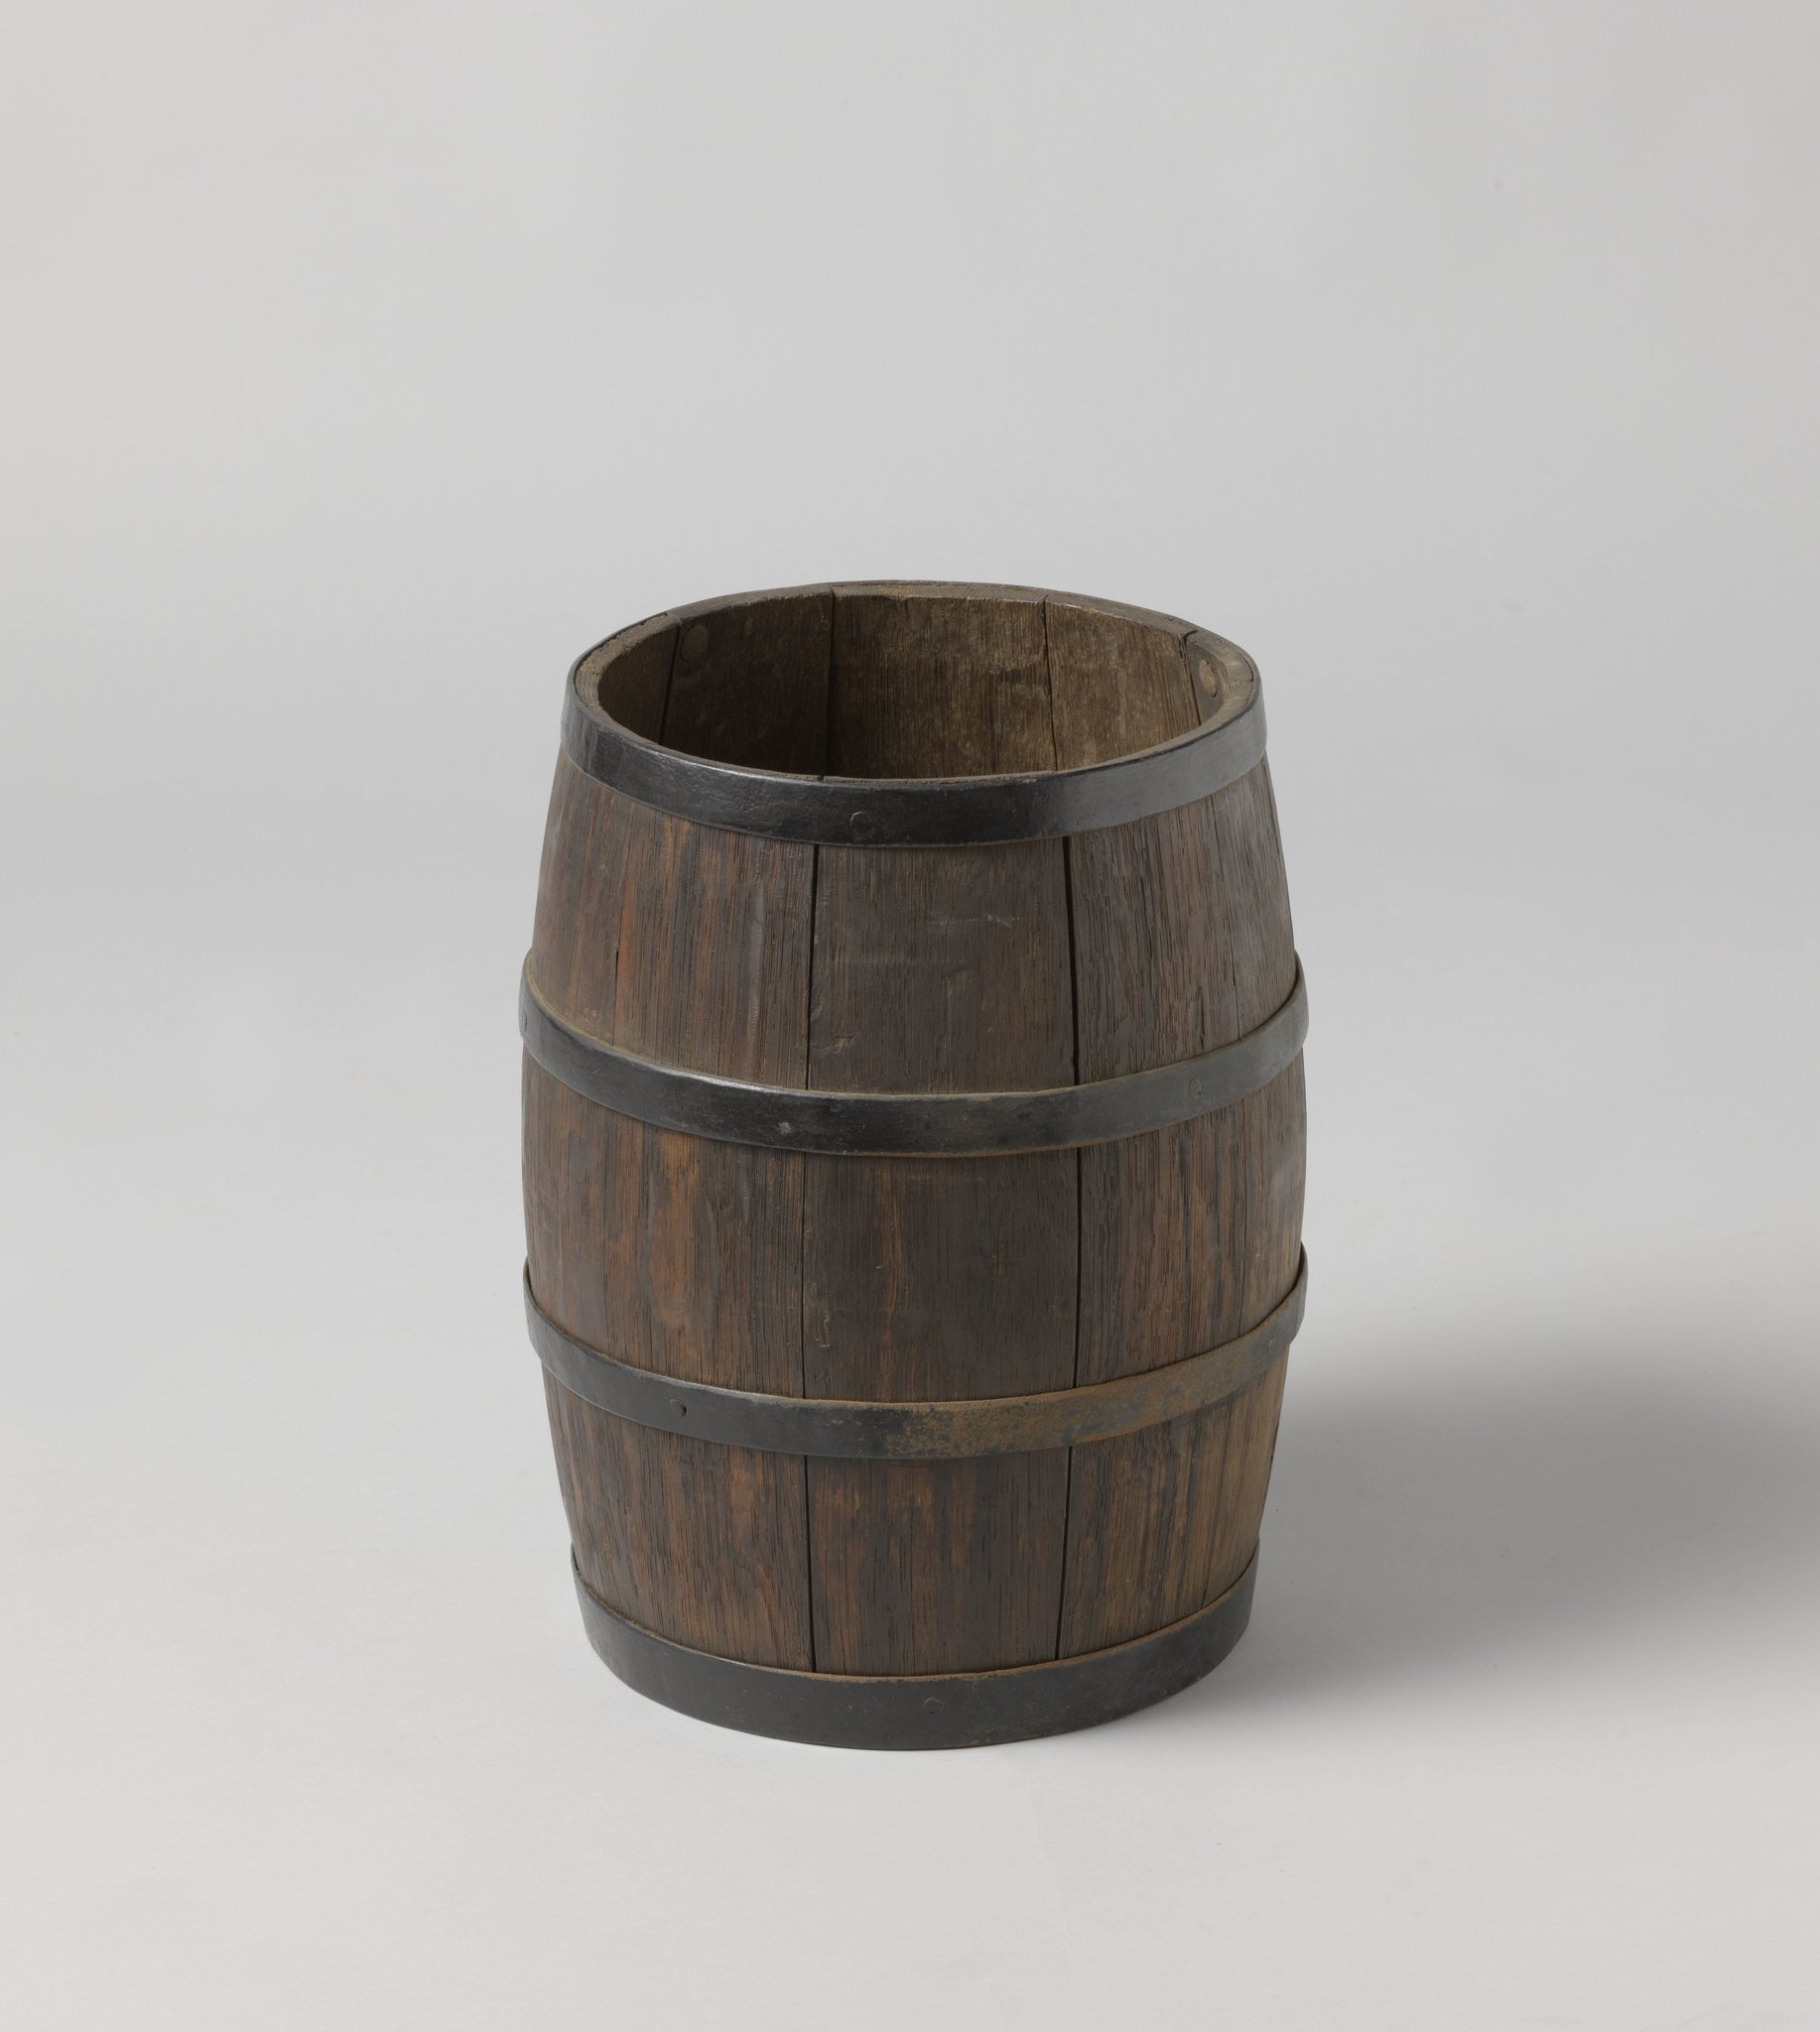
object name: inhoudsmaat droge waren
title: Maat van 20 liter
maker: Anonymous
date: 1700-1800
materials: iron, wood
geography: netherlands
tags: netherlands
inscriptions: inscription: ‘24’, inscription: ‘double decalit...’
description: Houten maat van 20 liter met ijzeren beslag, geduigd en v.z.v. etiket.